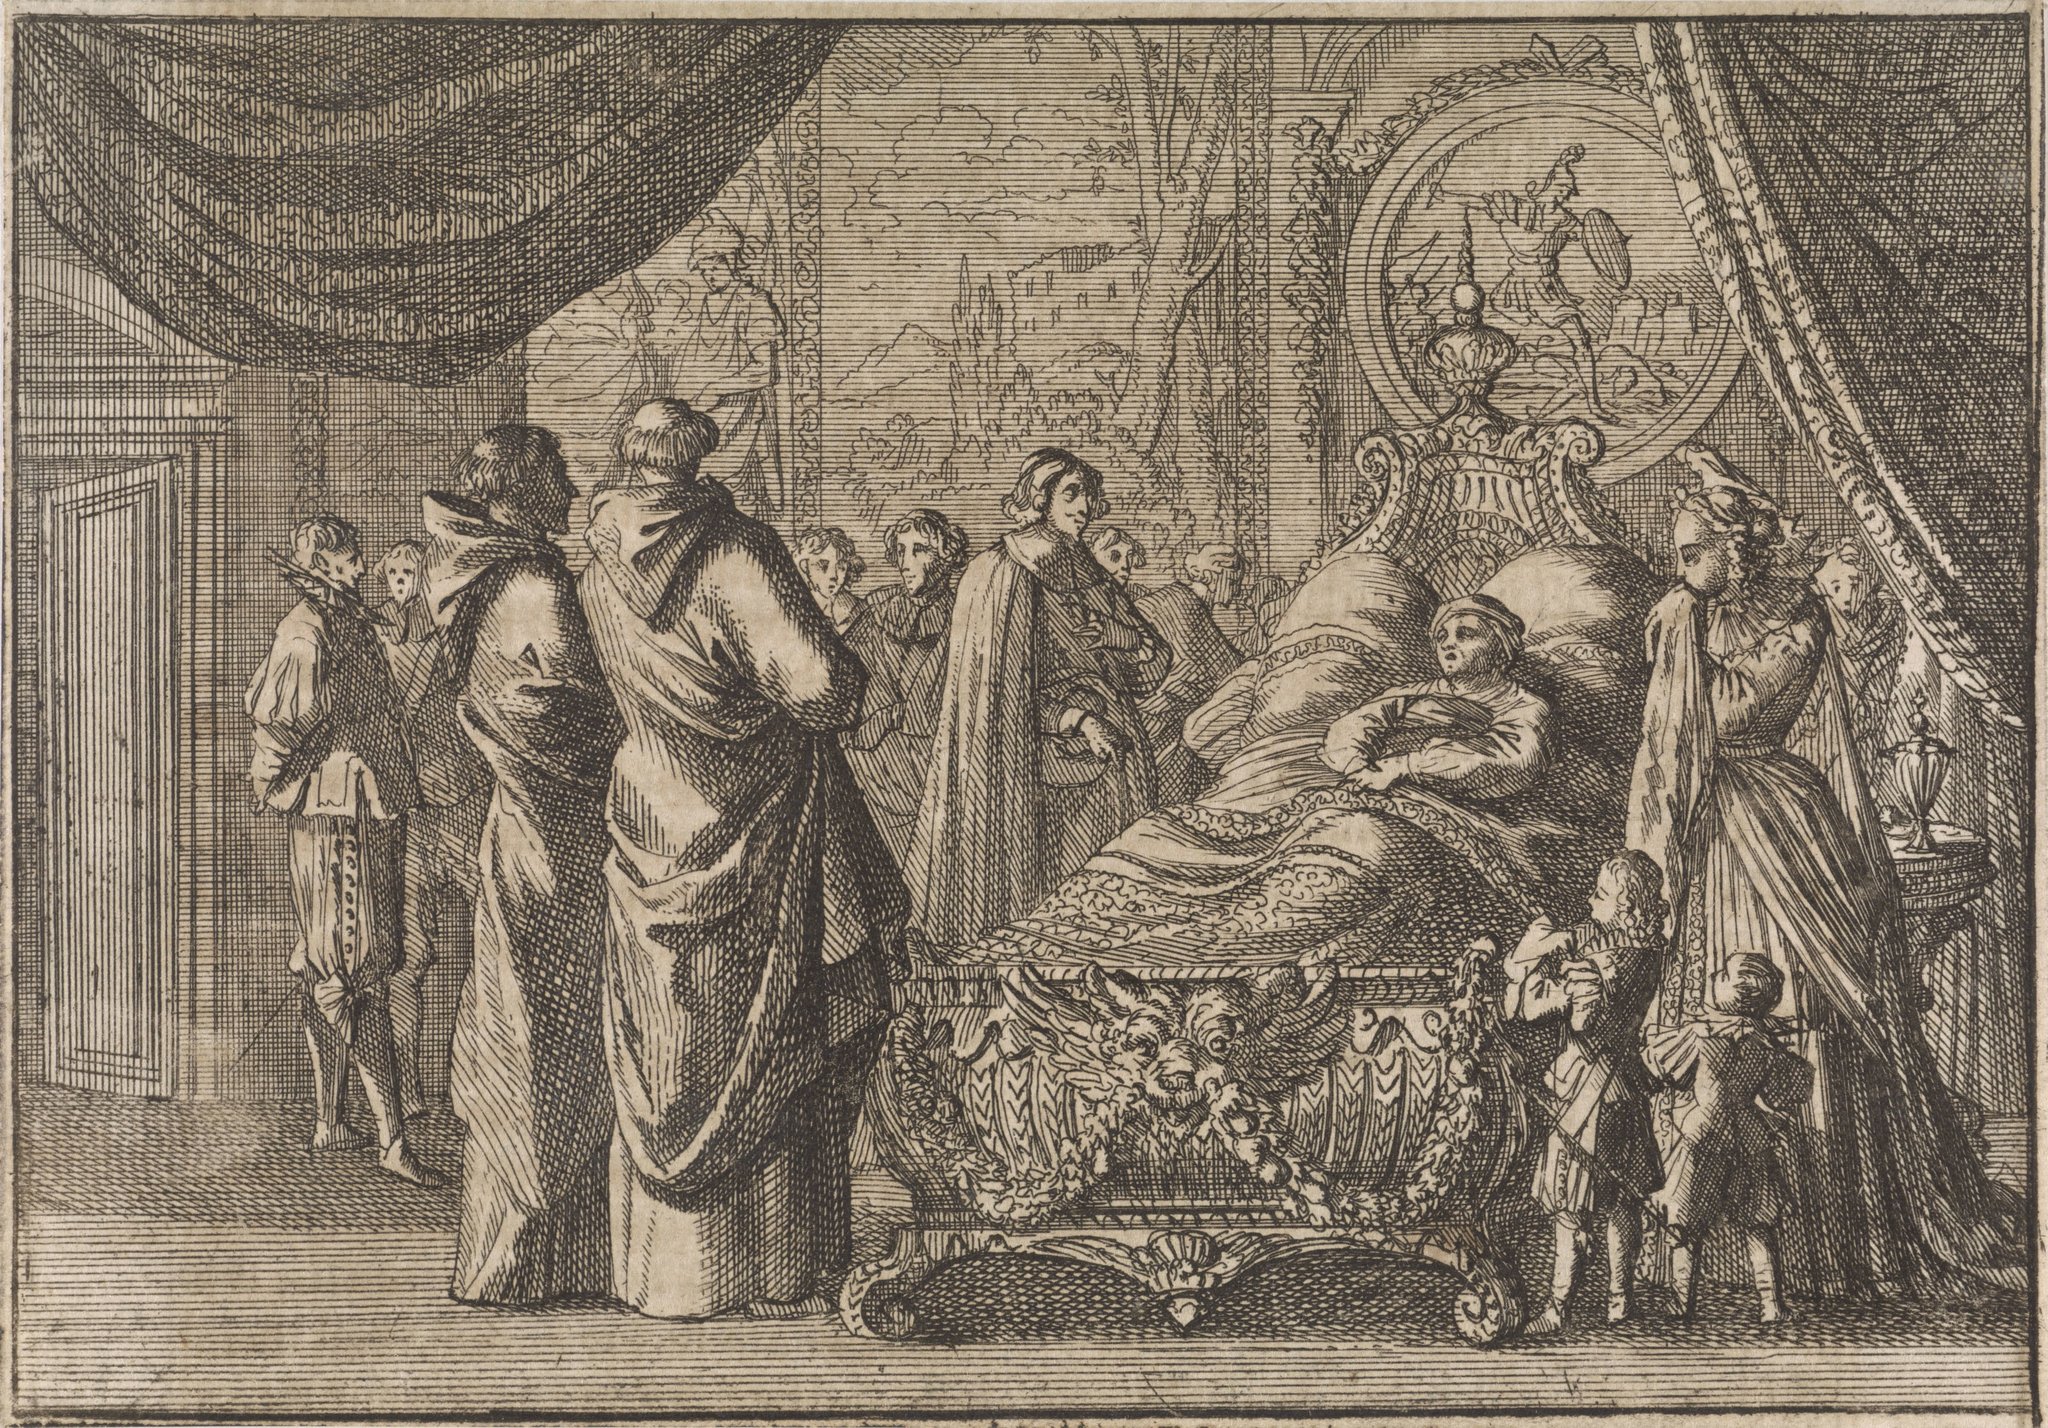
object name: history print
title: Sterfbed van Lodewijk XIII, 1643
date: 1701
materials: paper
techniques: etching, letterpress printing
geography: frankfurt am main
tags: paris, anna van oostenrijk (koningin van frankrijk), lodewijk xiv (koning van frankrijk), lodewijk xiii (koning van frankrijk), filips i (hertog van orléans), deathbed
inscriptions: collector's mark: Lugt 2228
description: Boekillustratie voor Hiob Ludolff. Allgemeine Schau-Bühne der Welt. Deel II. Frankfurt am Main: Johann David Zunnern, 1701, p. 1050.